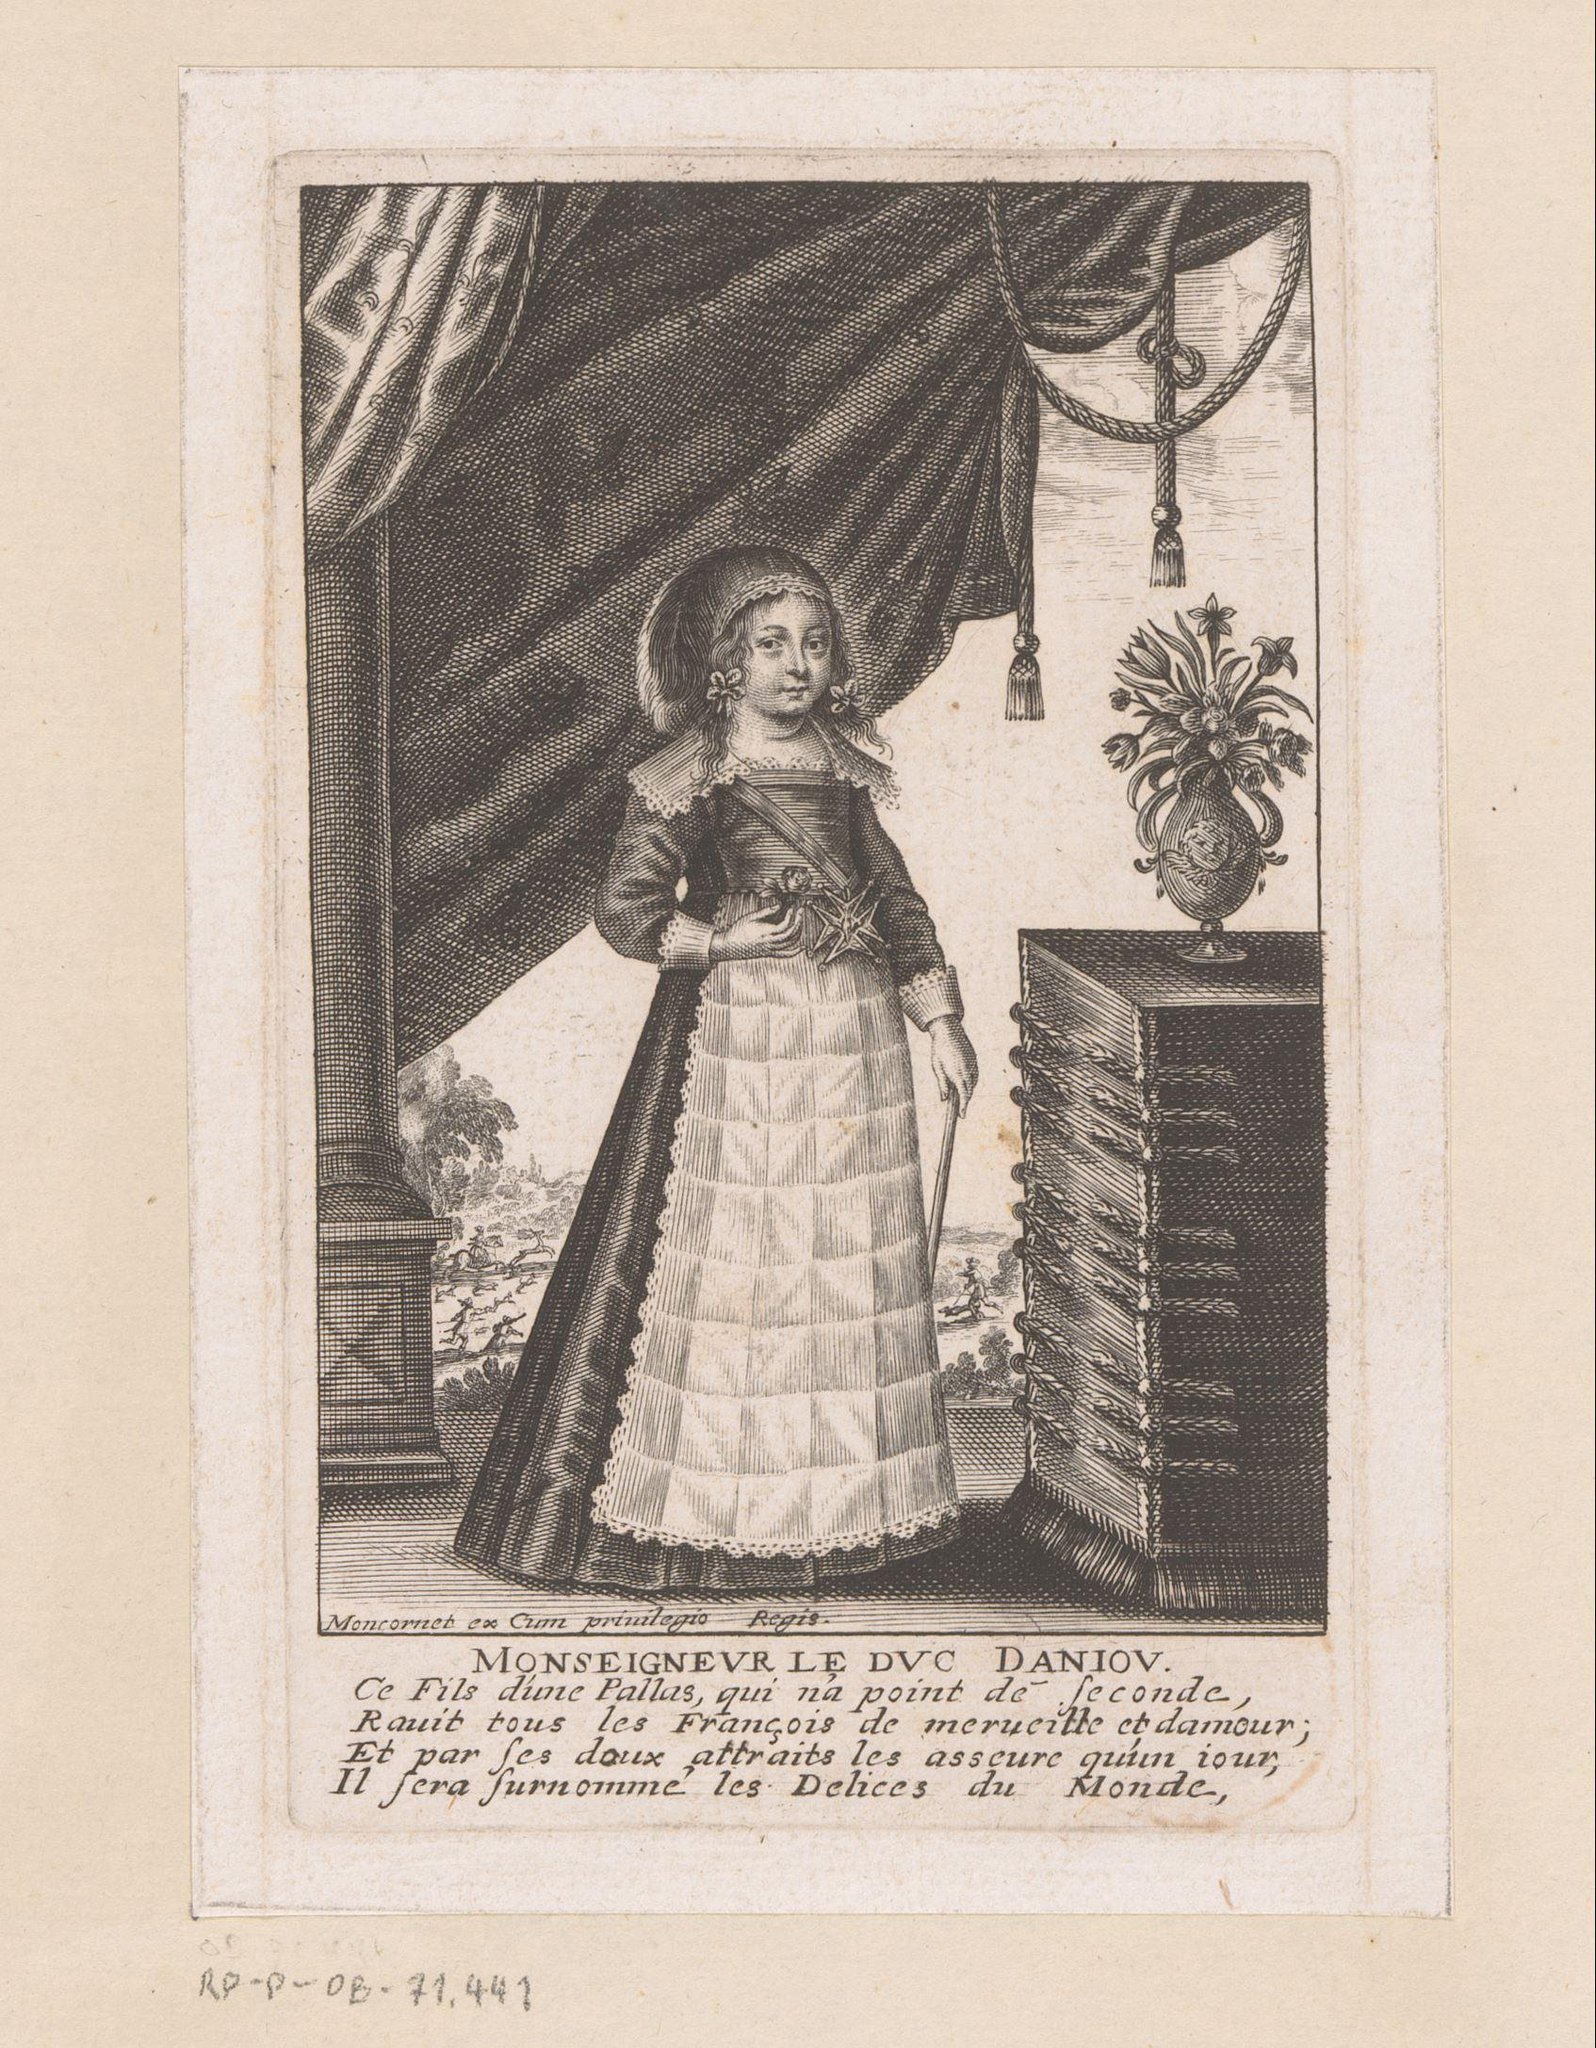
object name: print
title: Portret van Filips van Orléans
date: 1646-1668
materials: paper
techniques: engraving, etching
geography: france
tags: filips i (hertog van orléans), historical persons, nobility and patriciate; chivalry, knighthood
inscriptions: collector's mark: Lugt 240